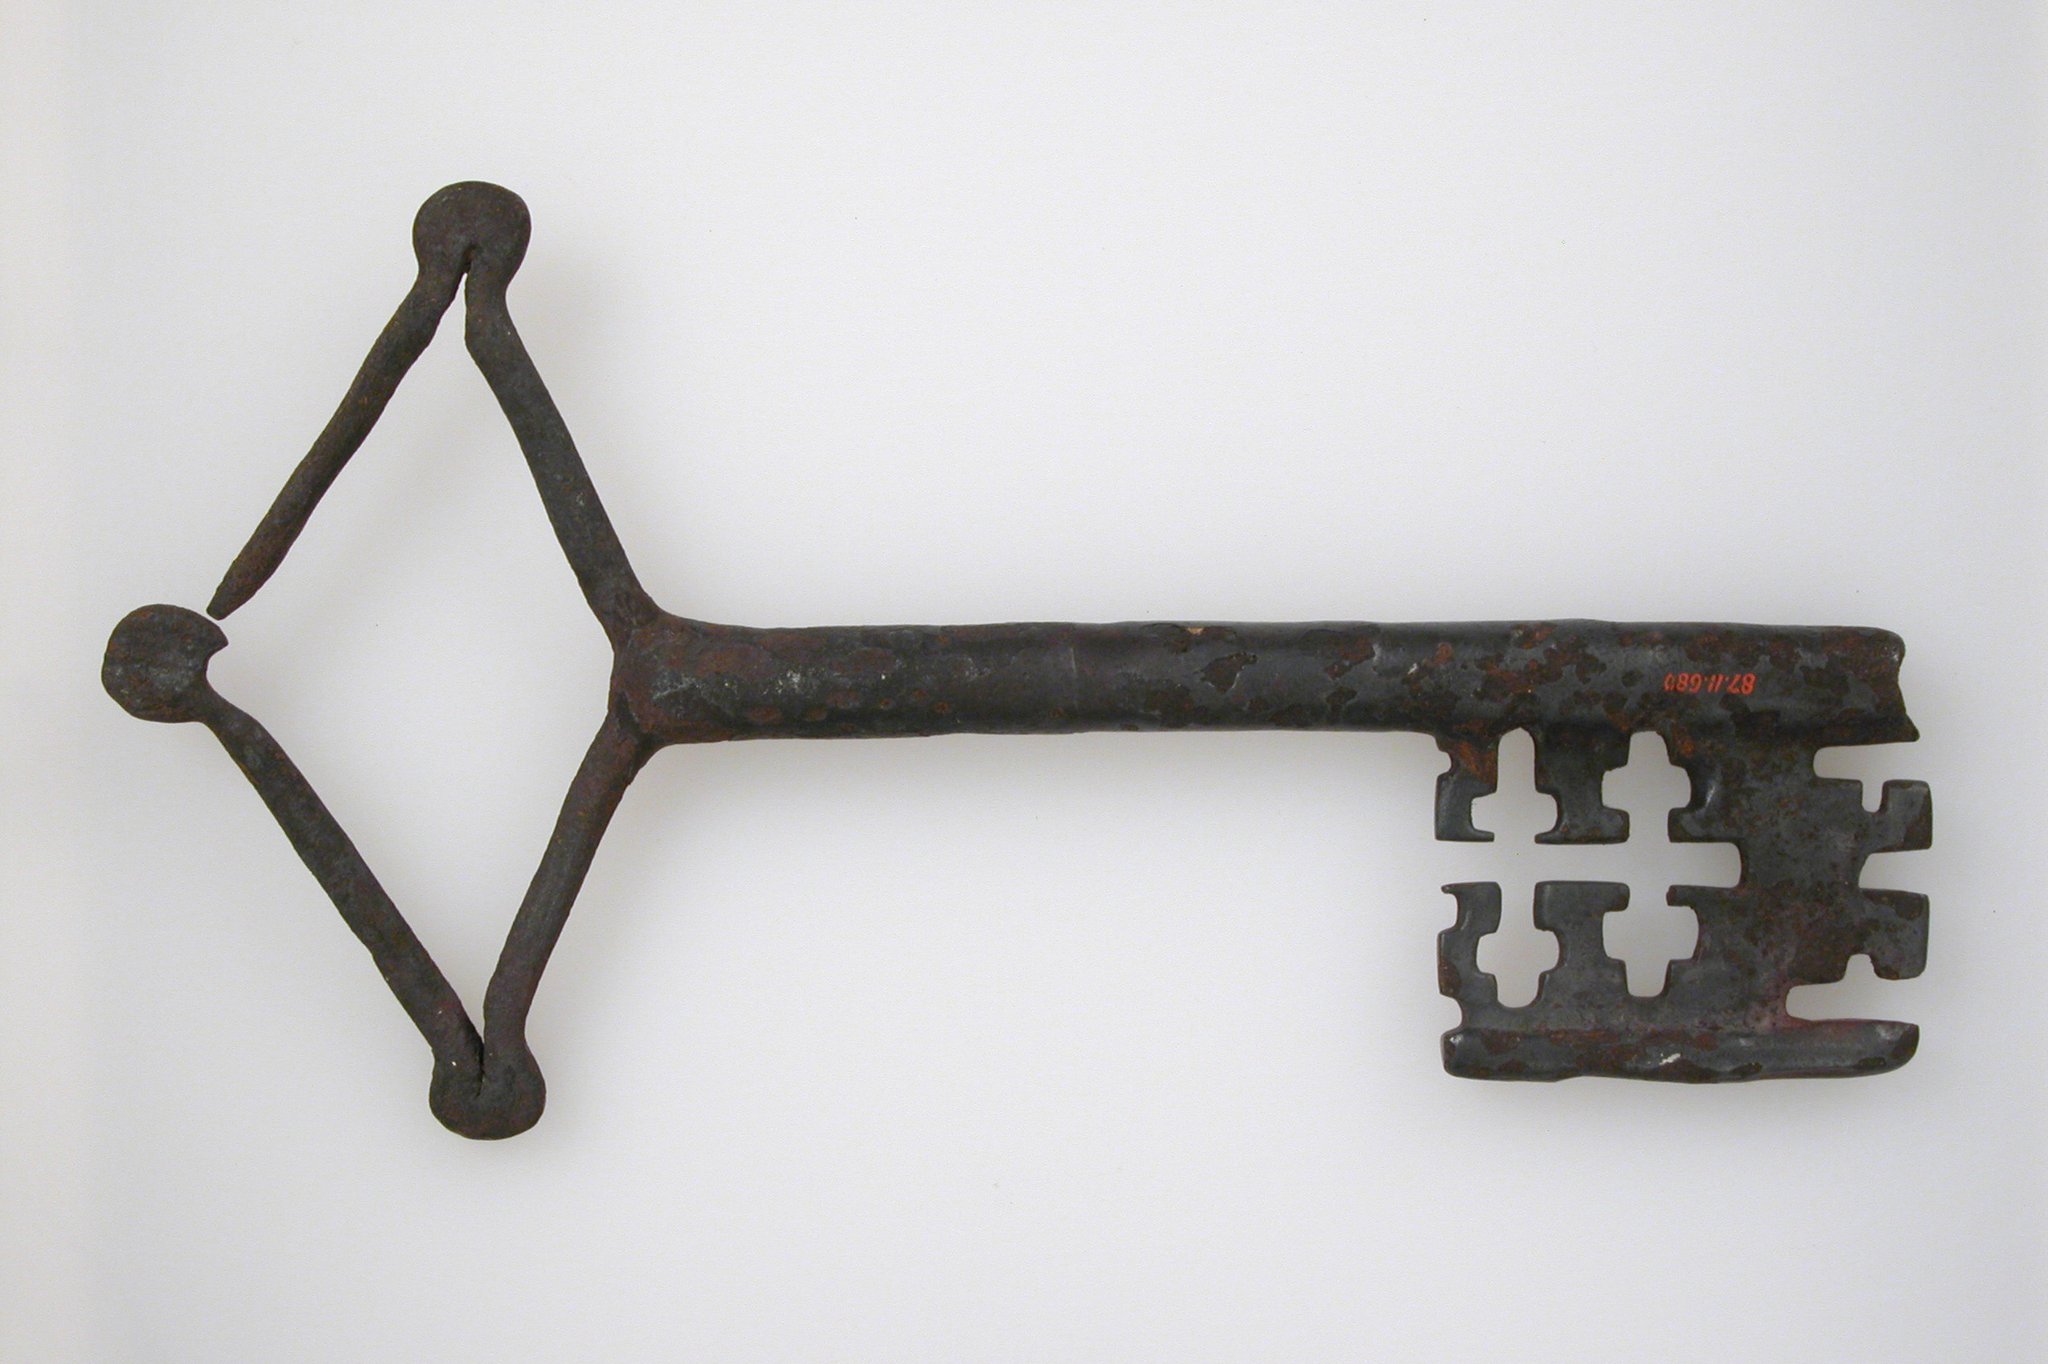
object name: key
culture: german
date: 1201-1300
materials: iron